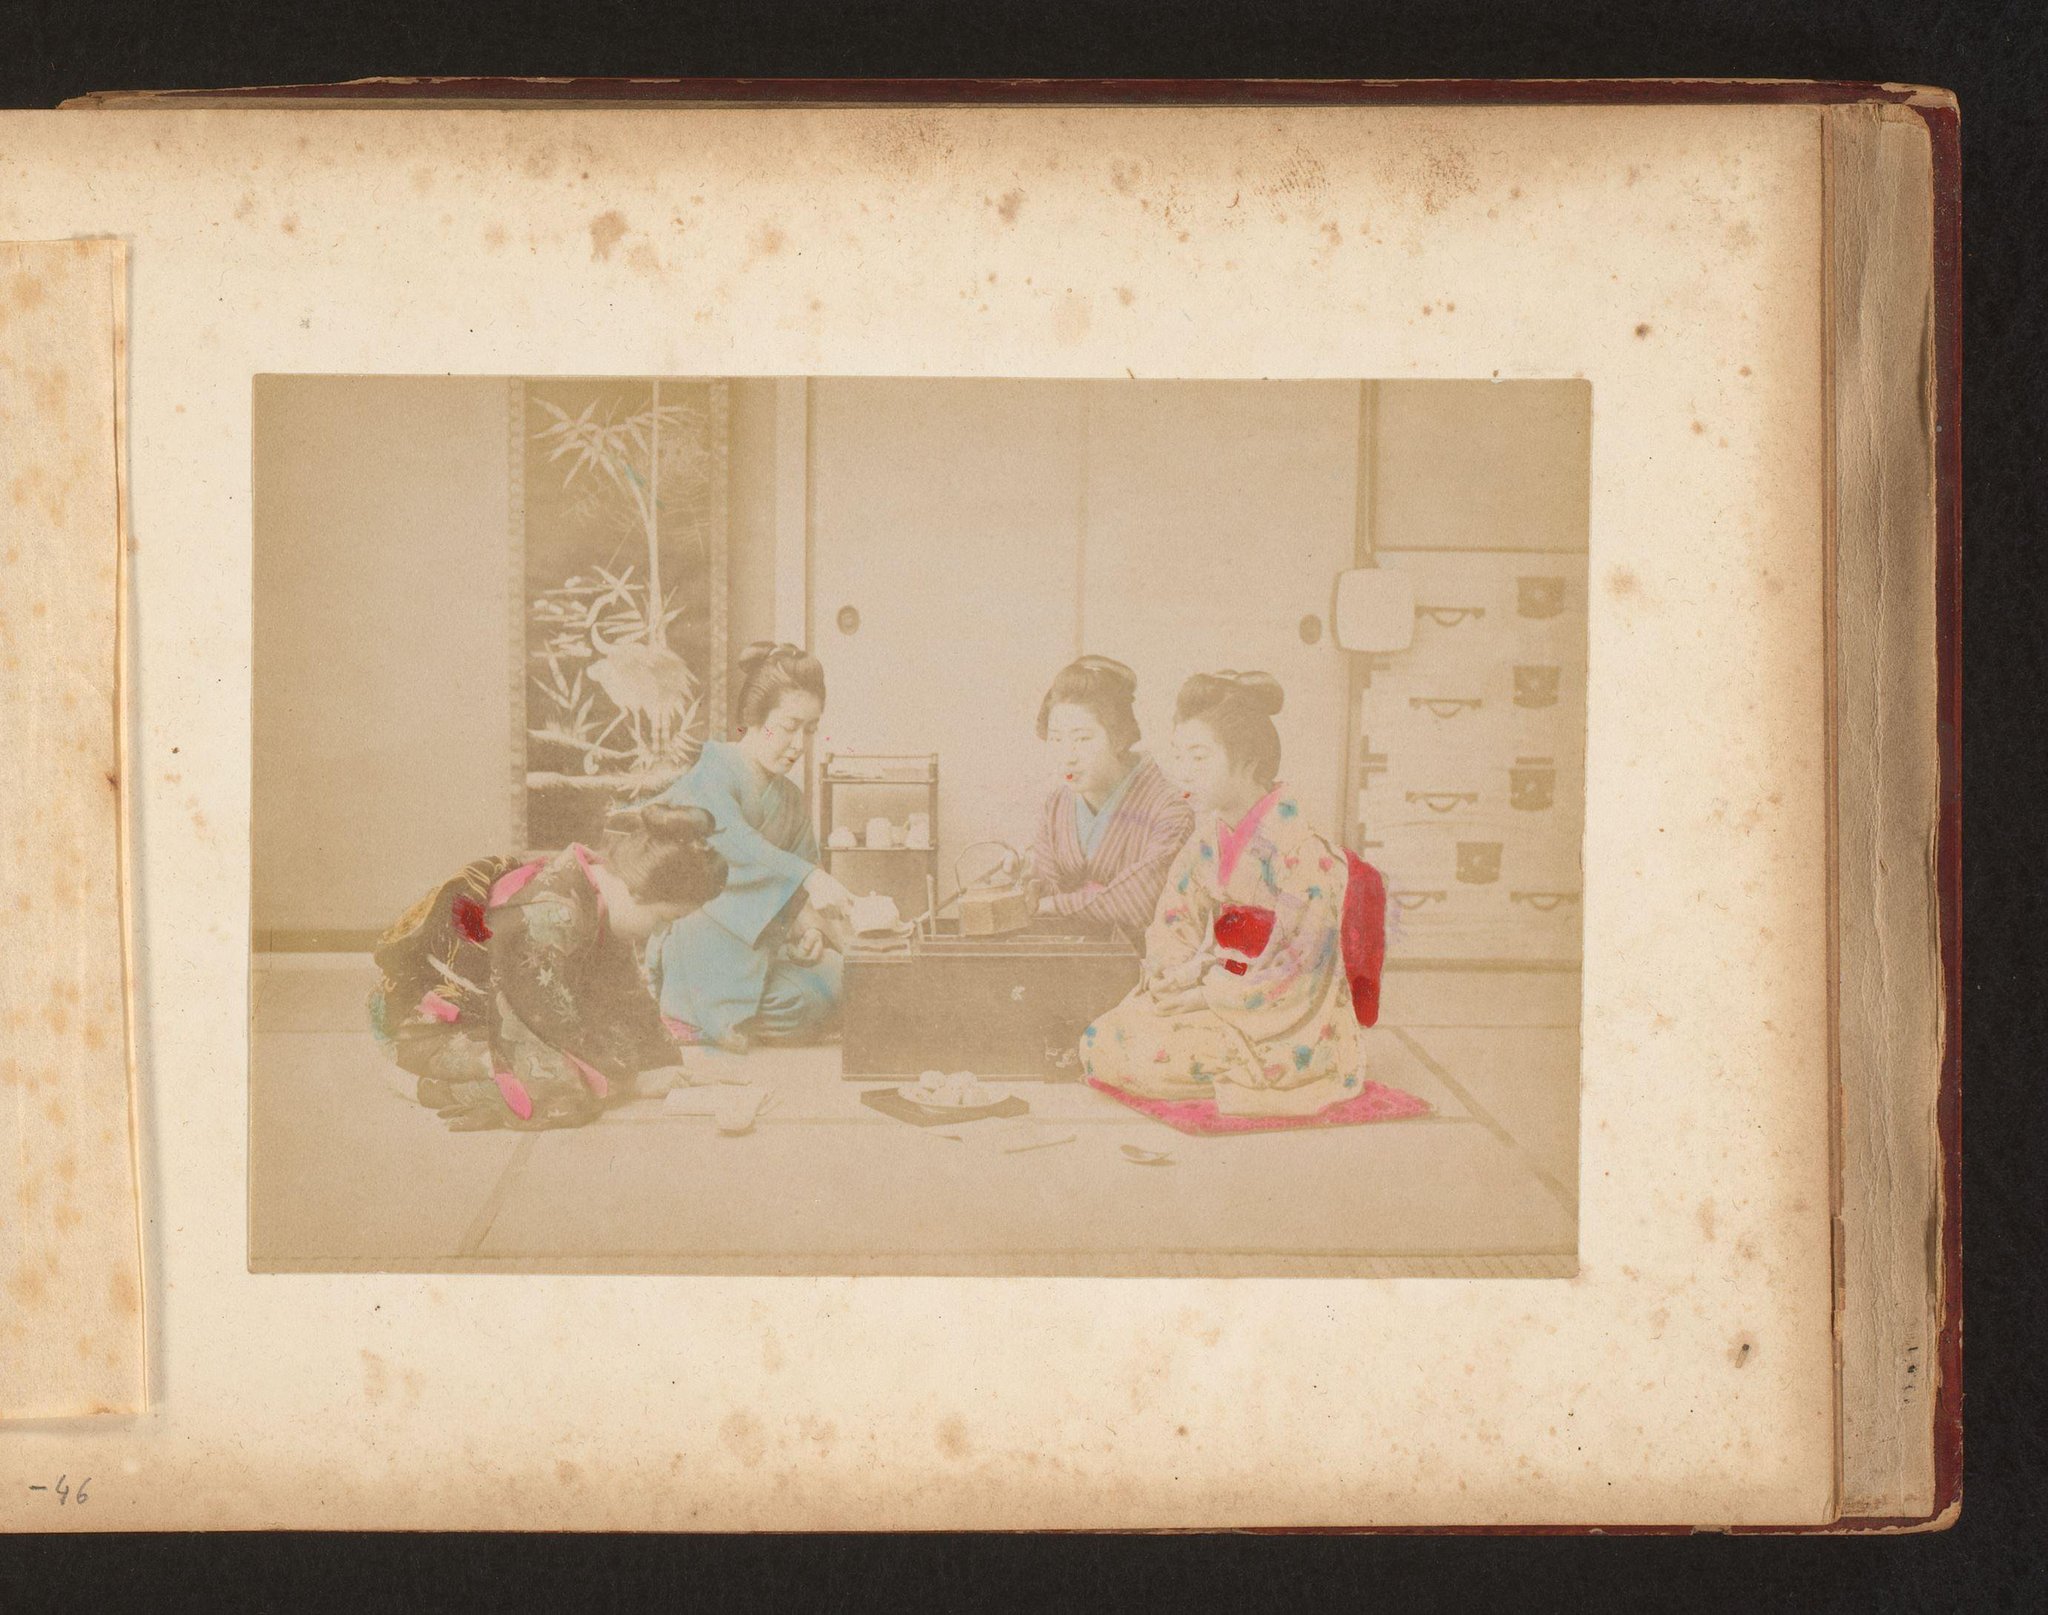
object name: photograph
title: Vier Japanse vrouwen tijdens een theeceremonie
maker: Anonymous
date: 1851-1900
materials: paper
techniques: albumen print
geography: japan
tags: adult woman, tea-ceremony, japan